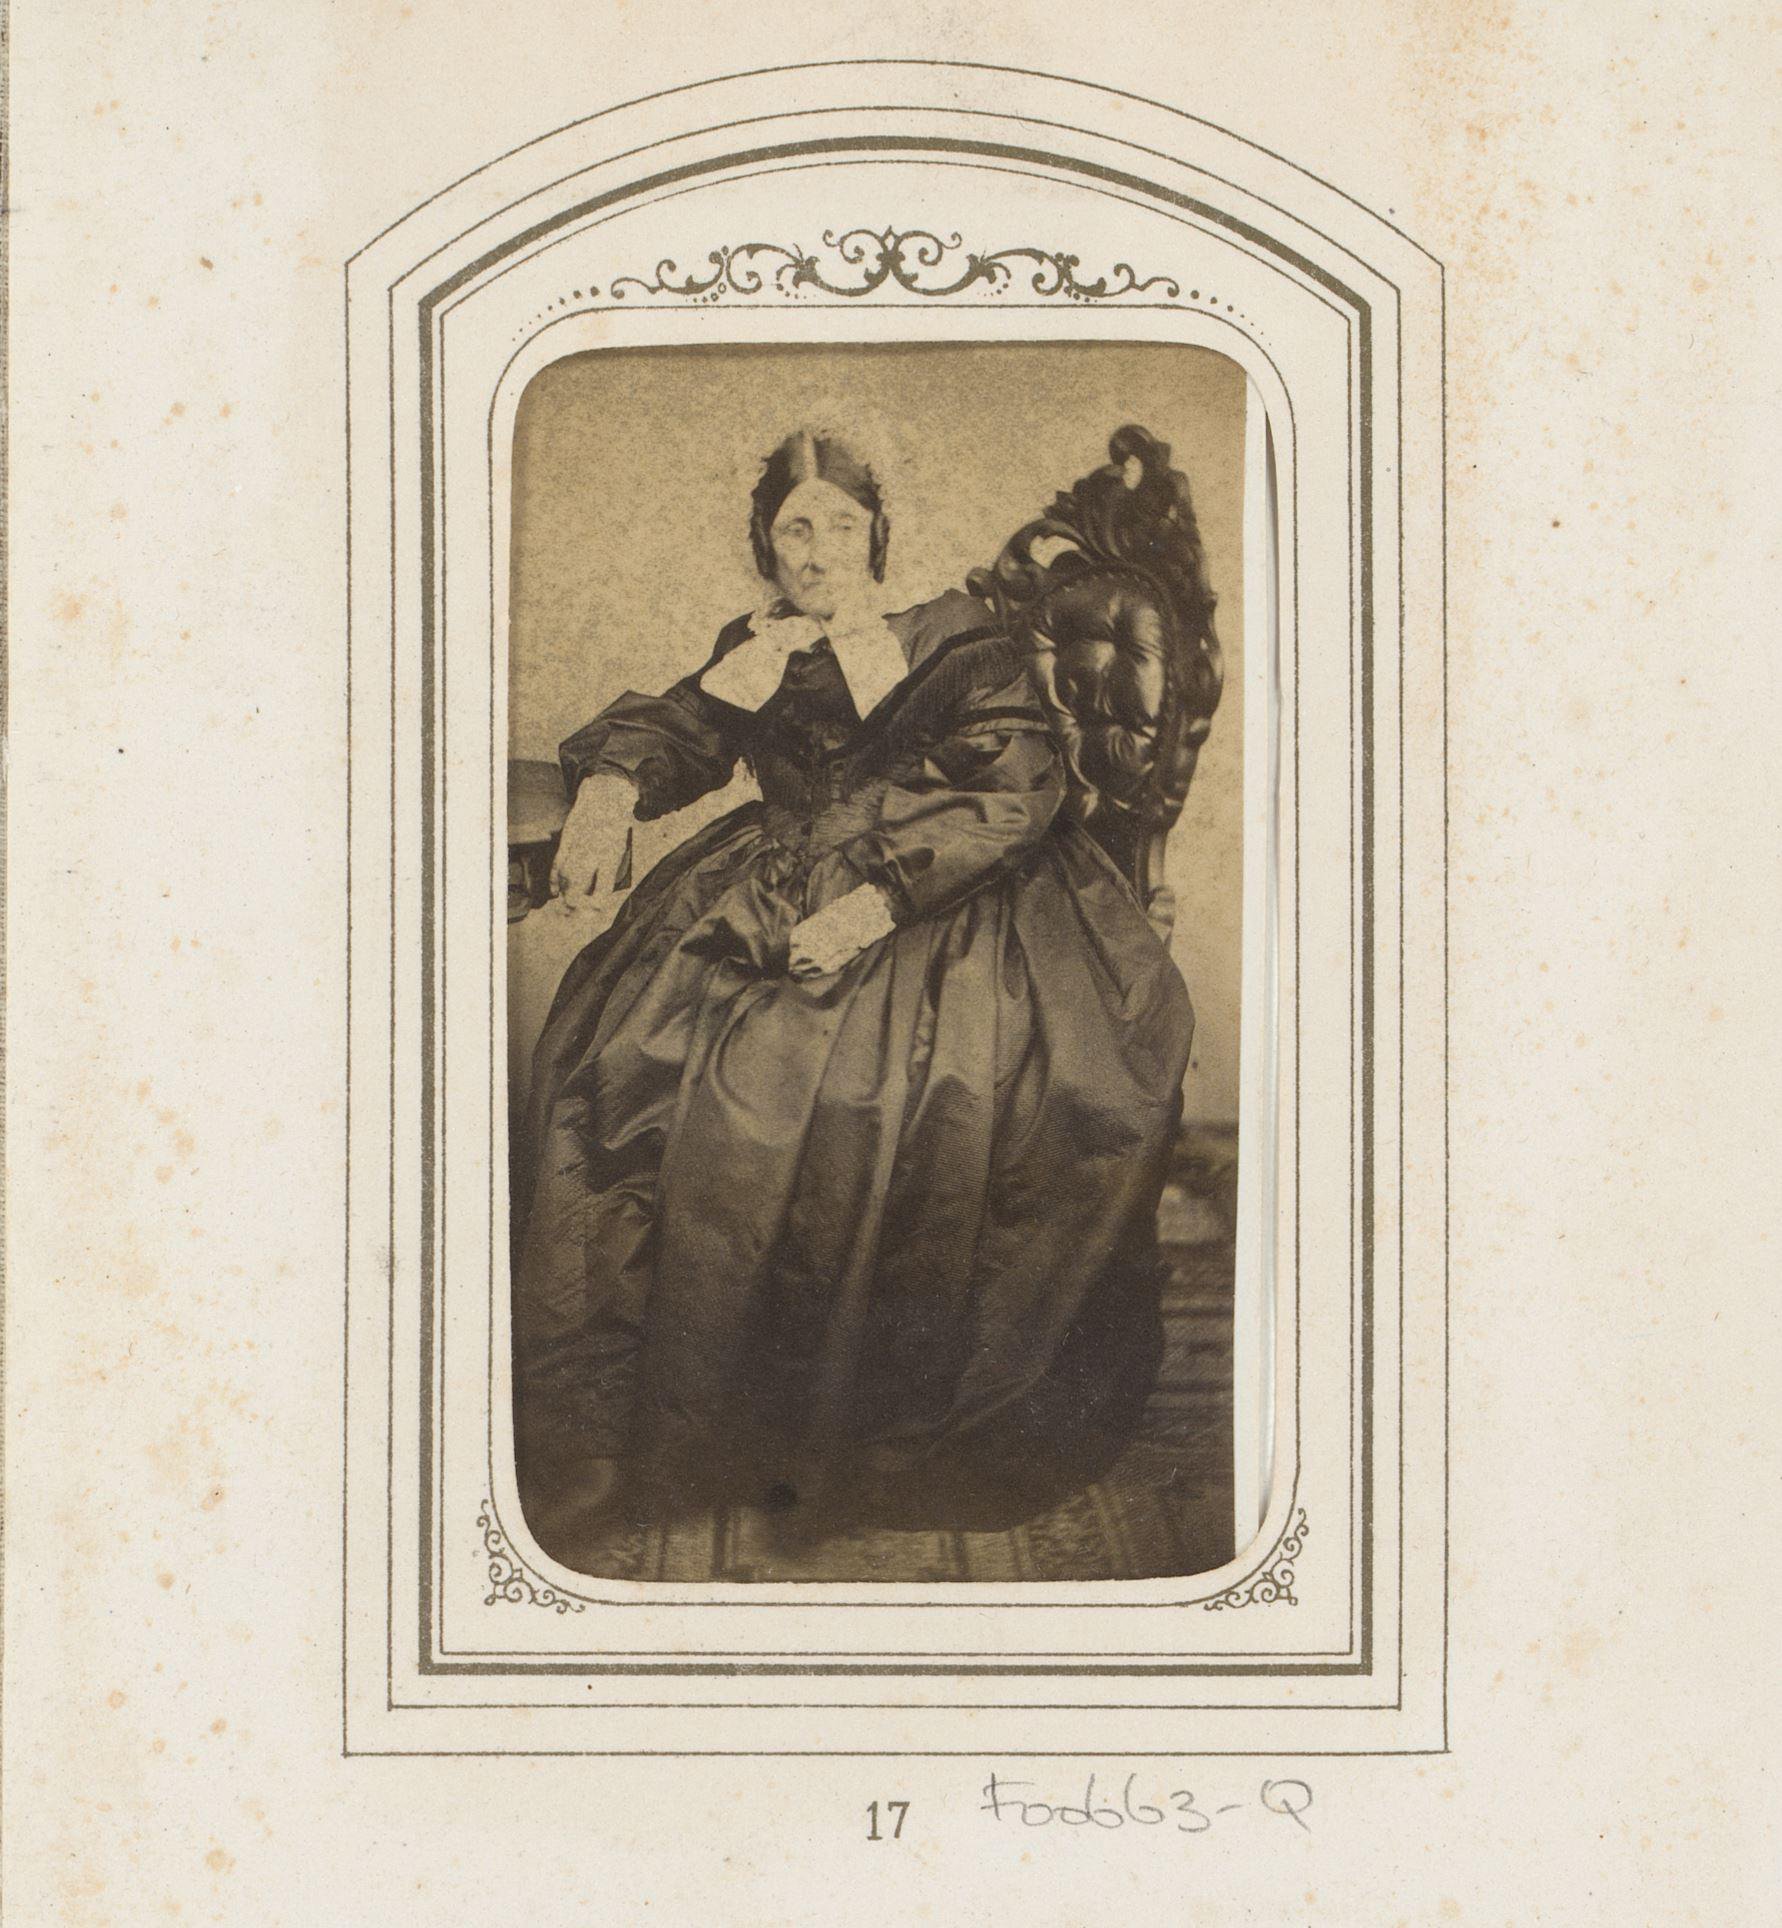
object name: photograph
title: Portret van een zittende oude vrouw met witte muts met linten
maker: hermanus siderius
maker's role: draughtsman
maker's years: 1819-1892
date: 1860-1870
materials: cardboard, photographic support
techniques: albumen print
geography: harlingen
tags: historical persons, old woman, head-gear: cap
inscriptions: number: ‘17’, inscription: ‘H. Siderius/ Harlingen’